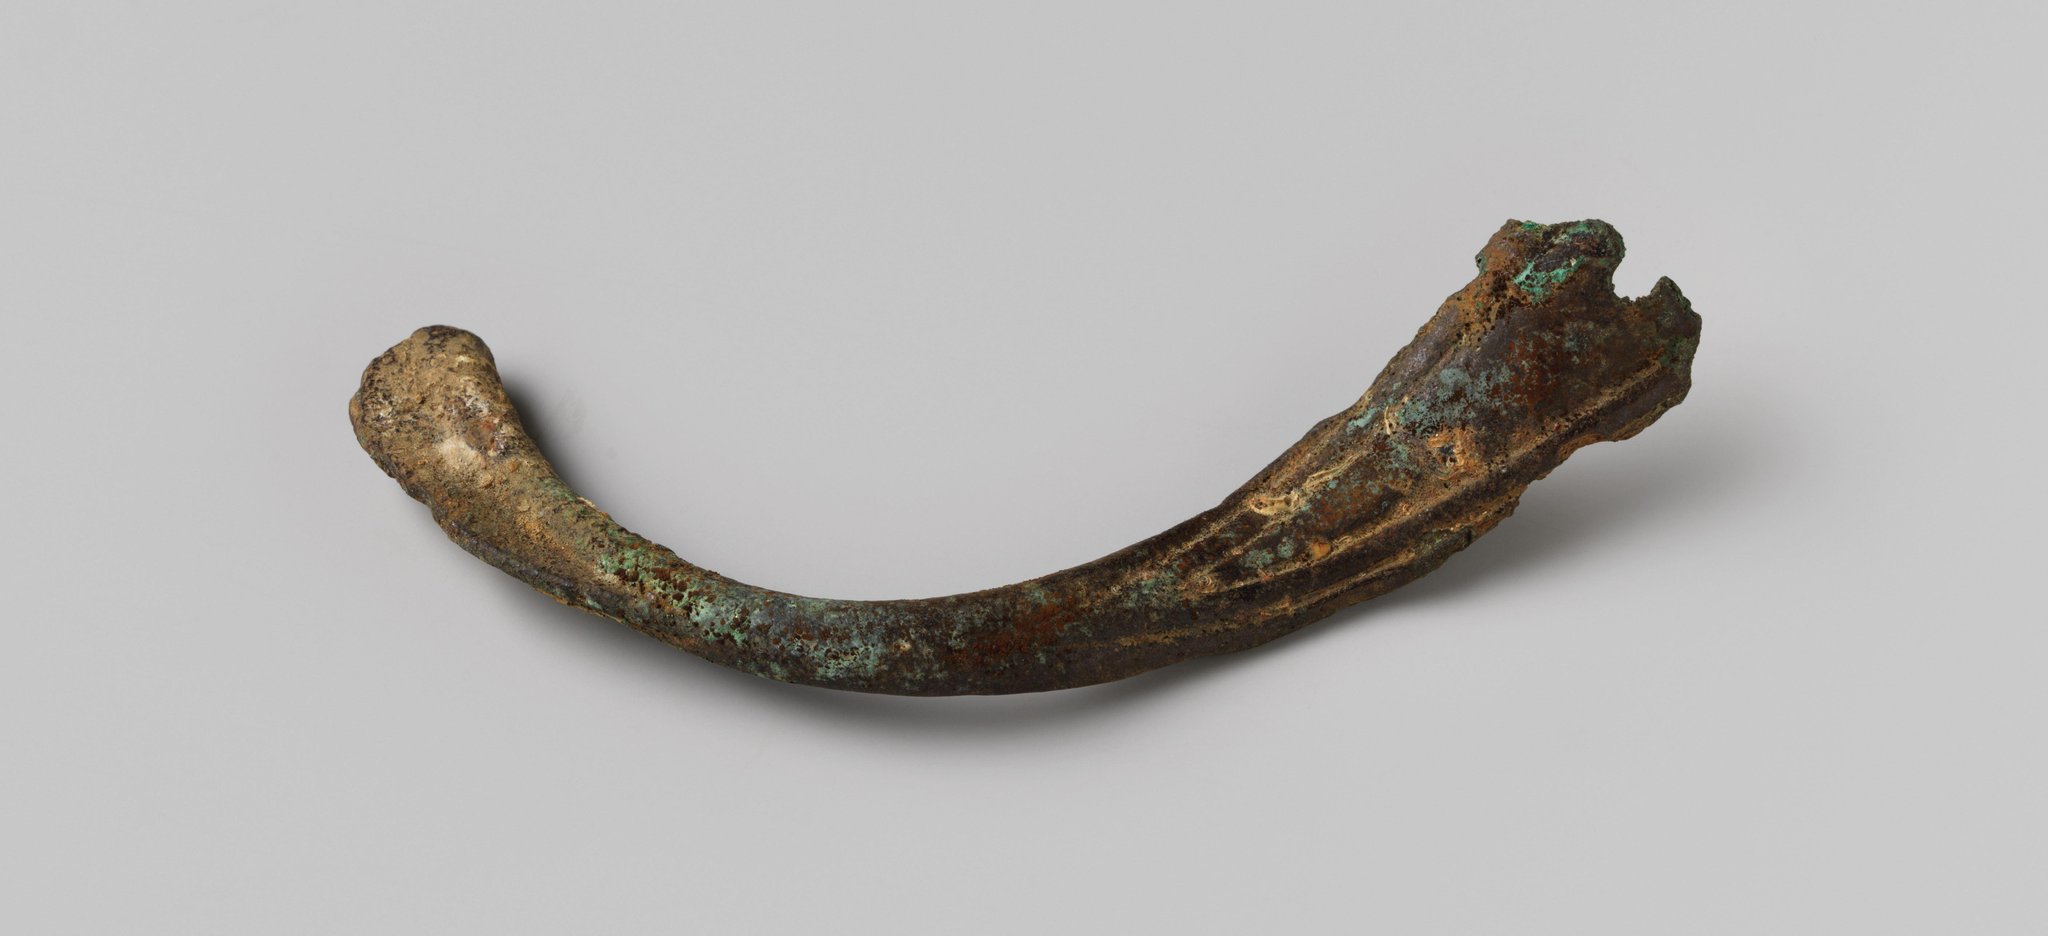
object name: fragment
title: Fragment van koperen steel uit het wrak van de Oost-Indiëvaarder Hollandia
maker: Anonymous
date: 1700-1743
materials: copper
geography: netherlands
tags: verenigde oostindische compagnie, hollandia (schip), annet